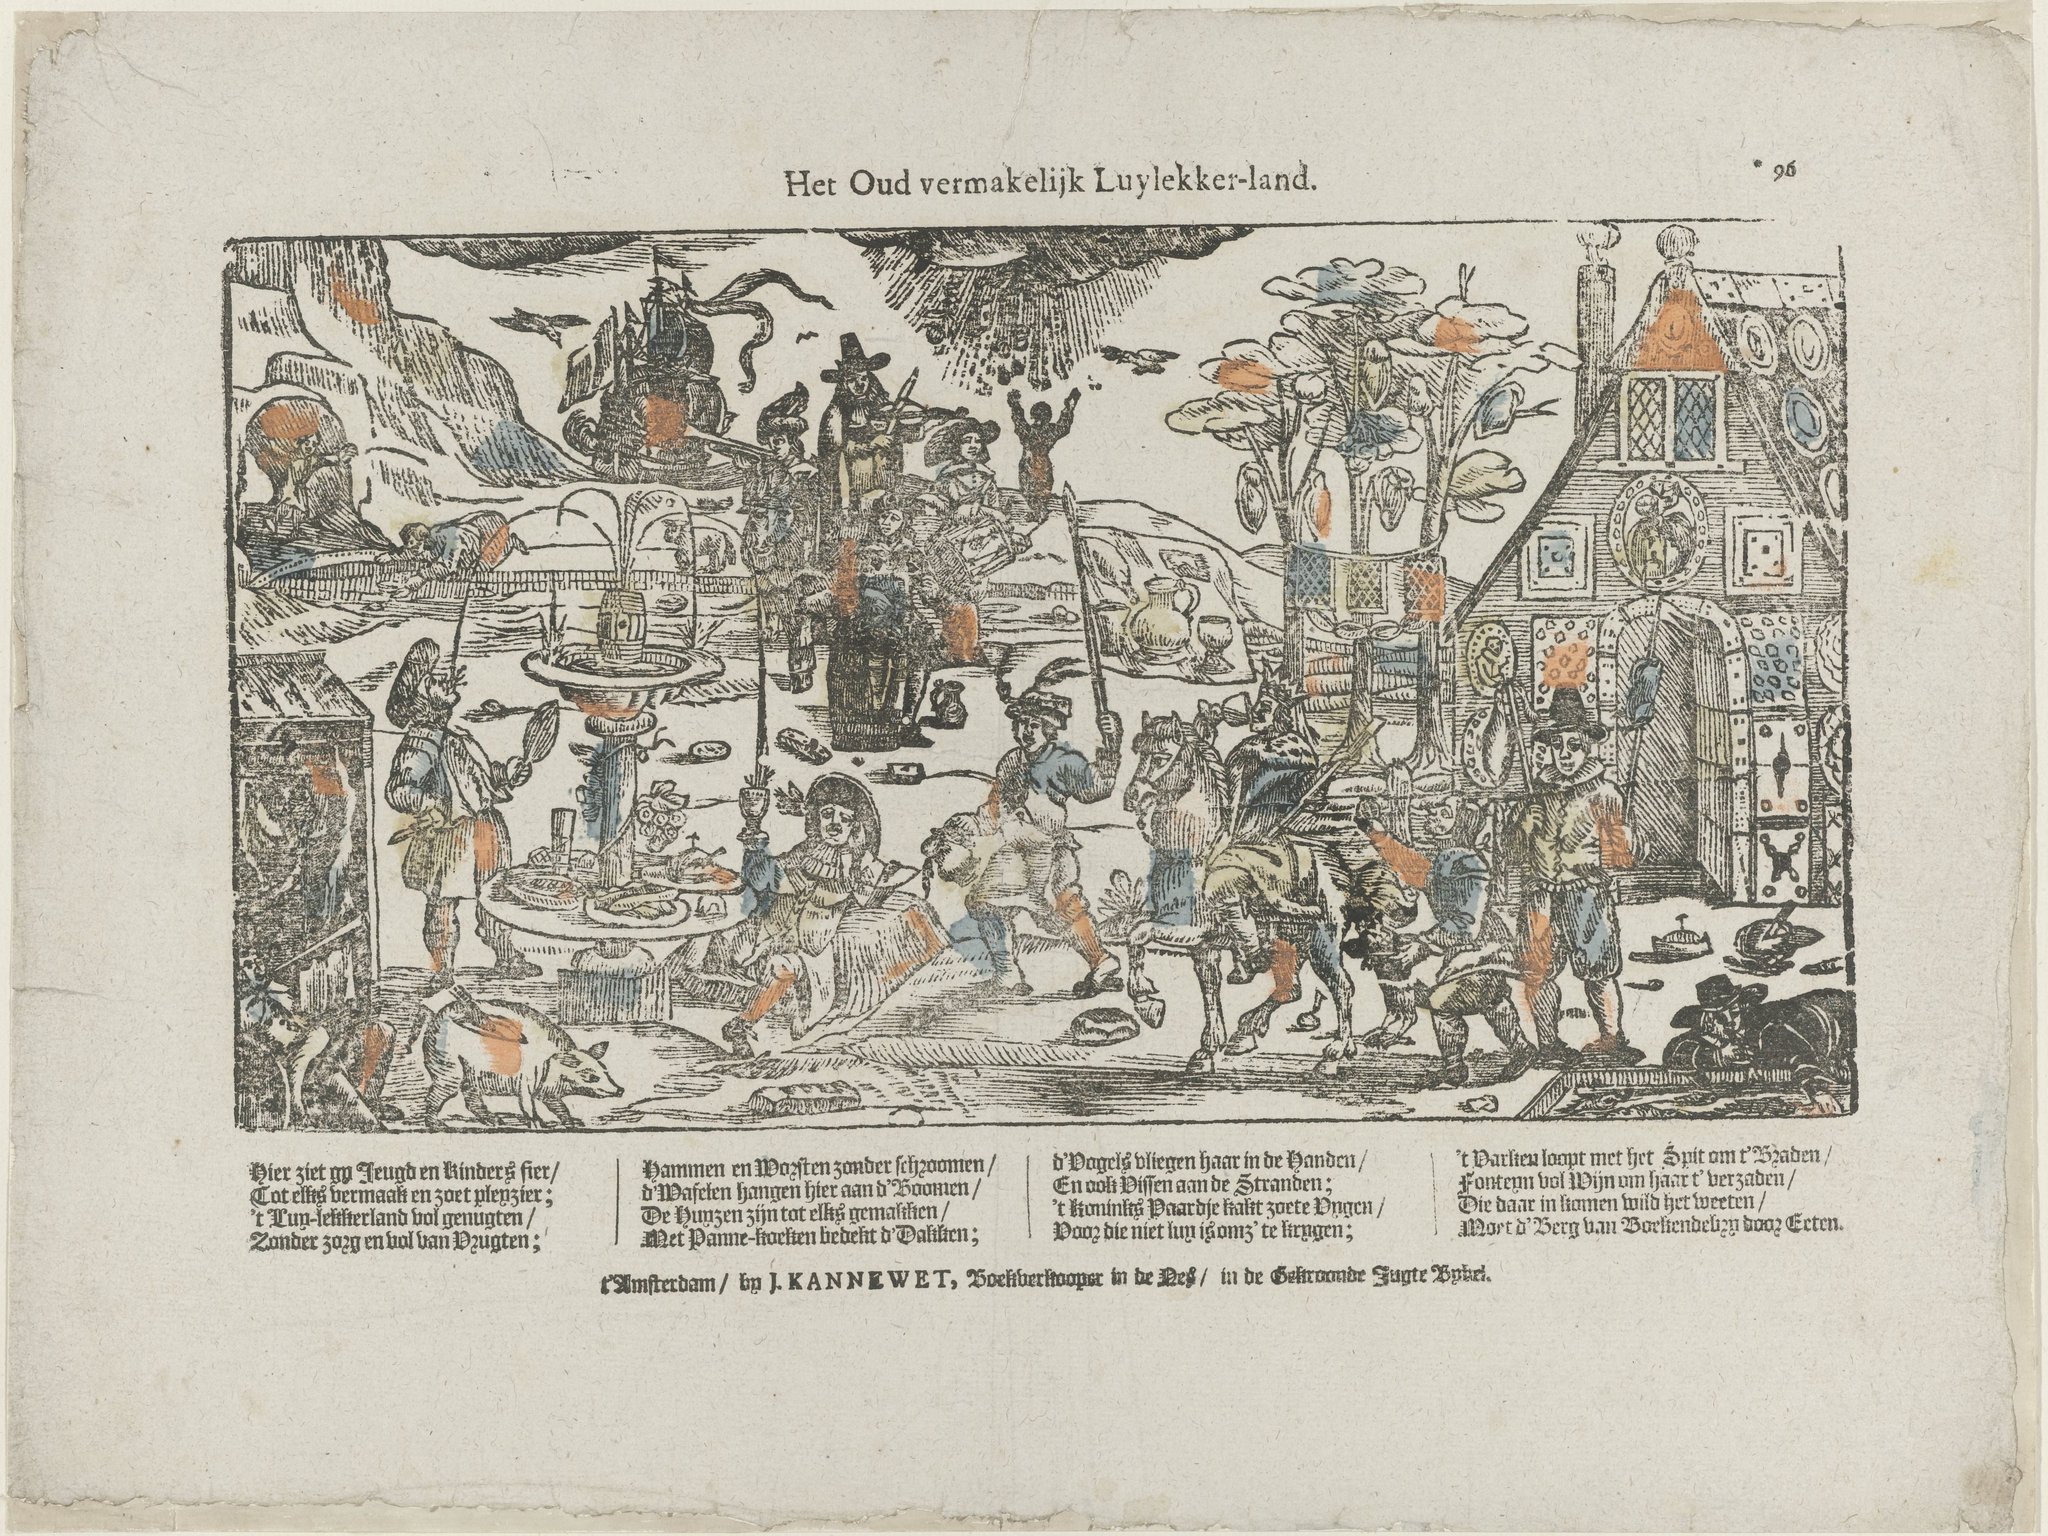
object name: popular print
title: Het oud vermakelijk luylekker-land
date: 1725-1780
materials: paper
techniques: colour, letterpress printing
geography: netherlands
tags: land of cockaigne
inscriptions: collector's mark: Lugt 2760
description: Blad met een grote voorstelling van feestende en etende mensen in het Luilekkerland. Er komt drank uit een fontein, er hangt vlees in de bomen en er komt eten uit de lucht vallen. Onder de voorstelling een onderschrift in vier kolommen. Genummerd rechtsboven: *96.